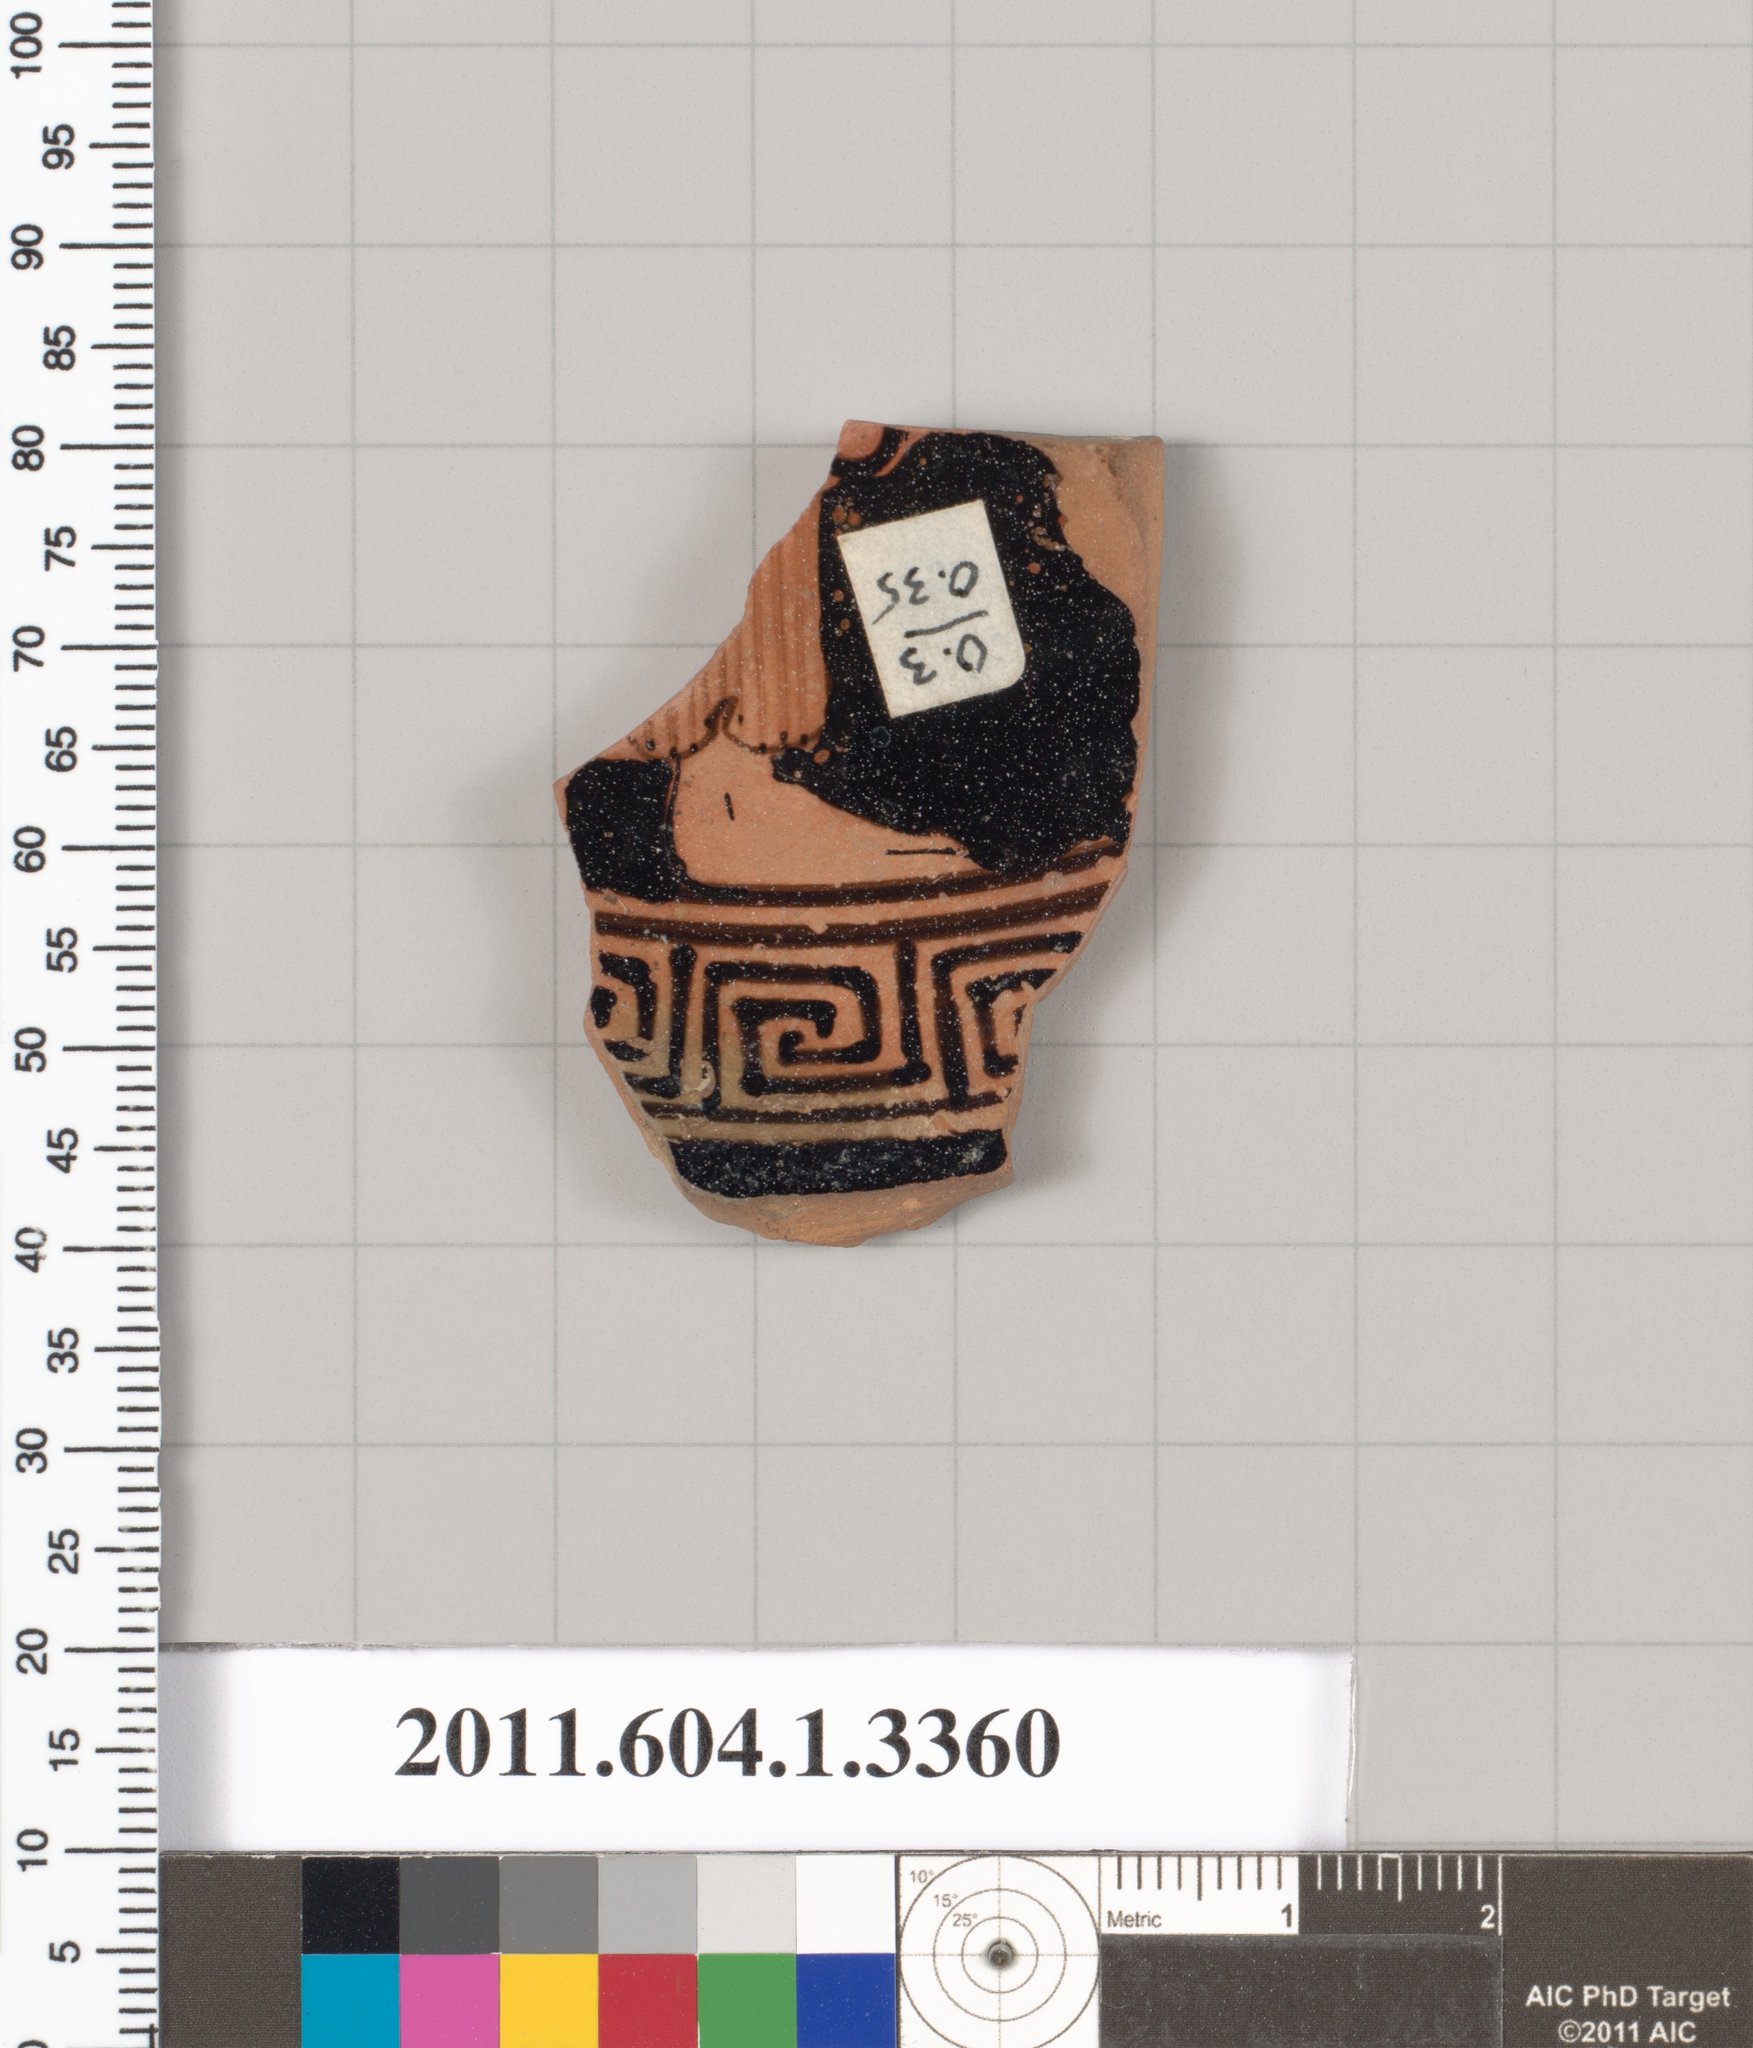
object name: kylix fragment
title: Terracotta fragment of a kylix (drinking cup)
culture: greek, attic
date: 475-451 BCE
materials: terracotta